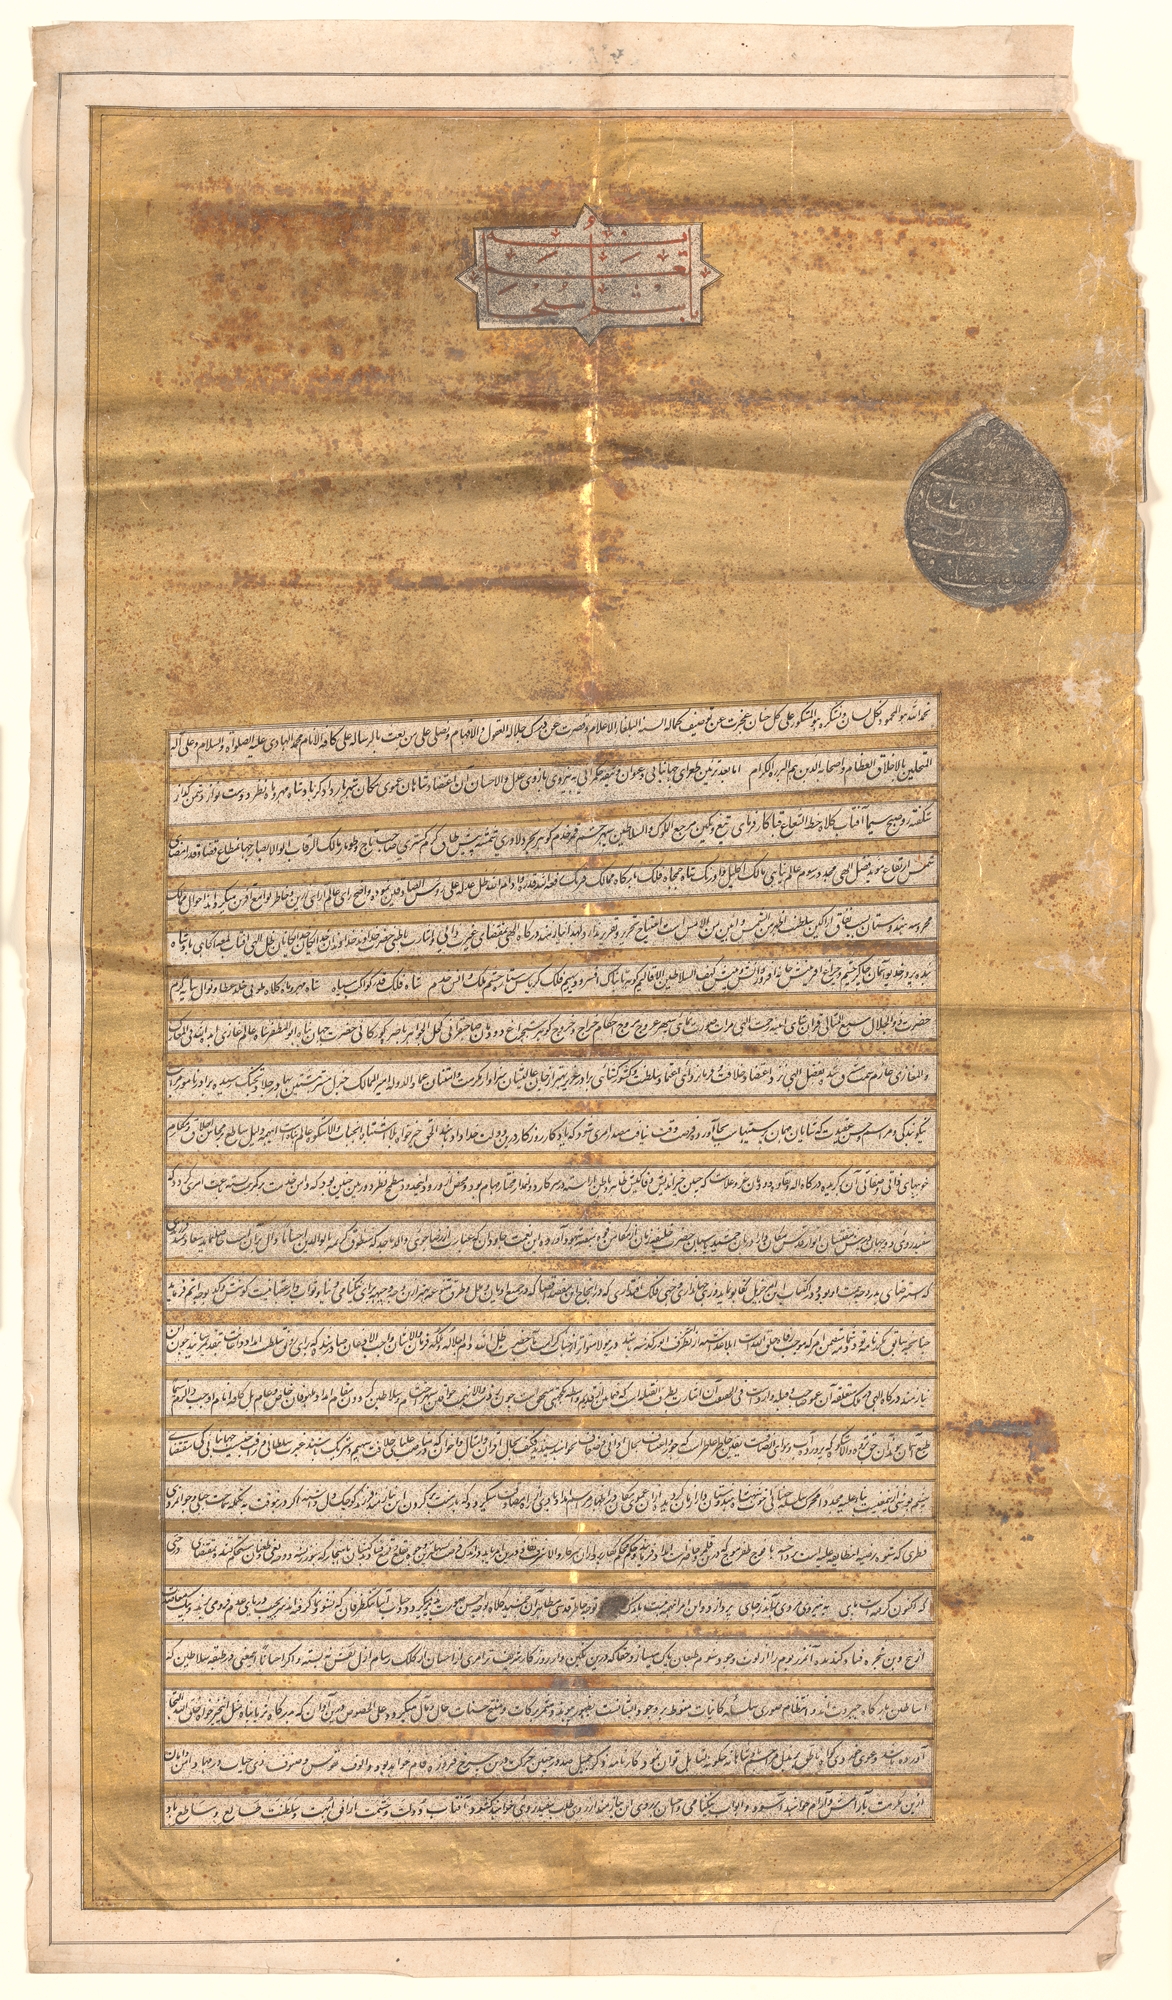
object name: non illustrated single work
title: Two Late Mughal Letters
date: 1780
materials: gold, ink, paper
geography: india